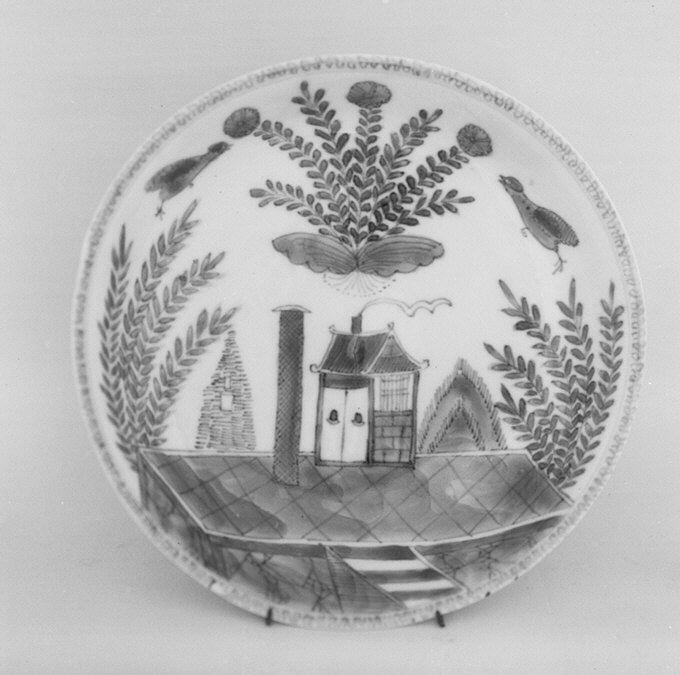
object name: saucer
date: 1710-1730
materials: hard paste porcelain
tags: birds,houses,flowers